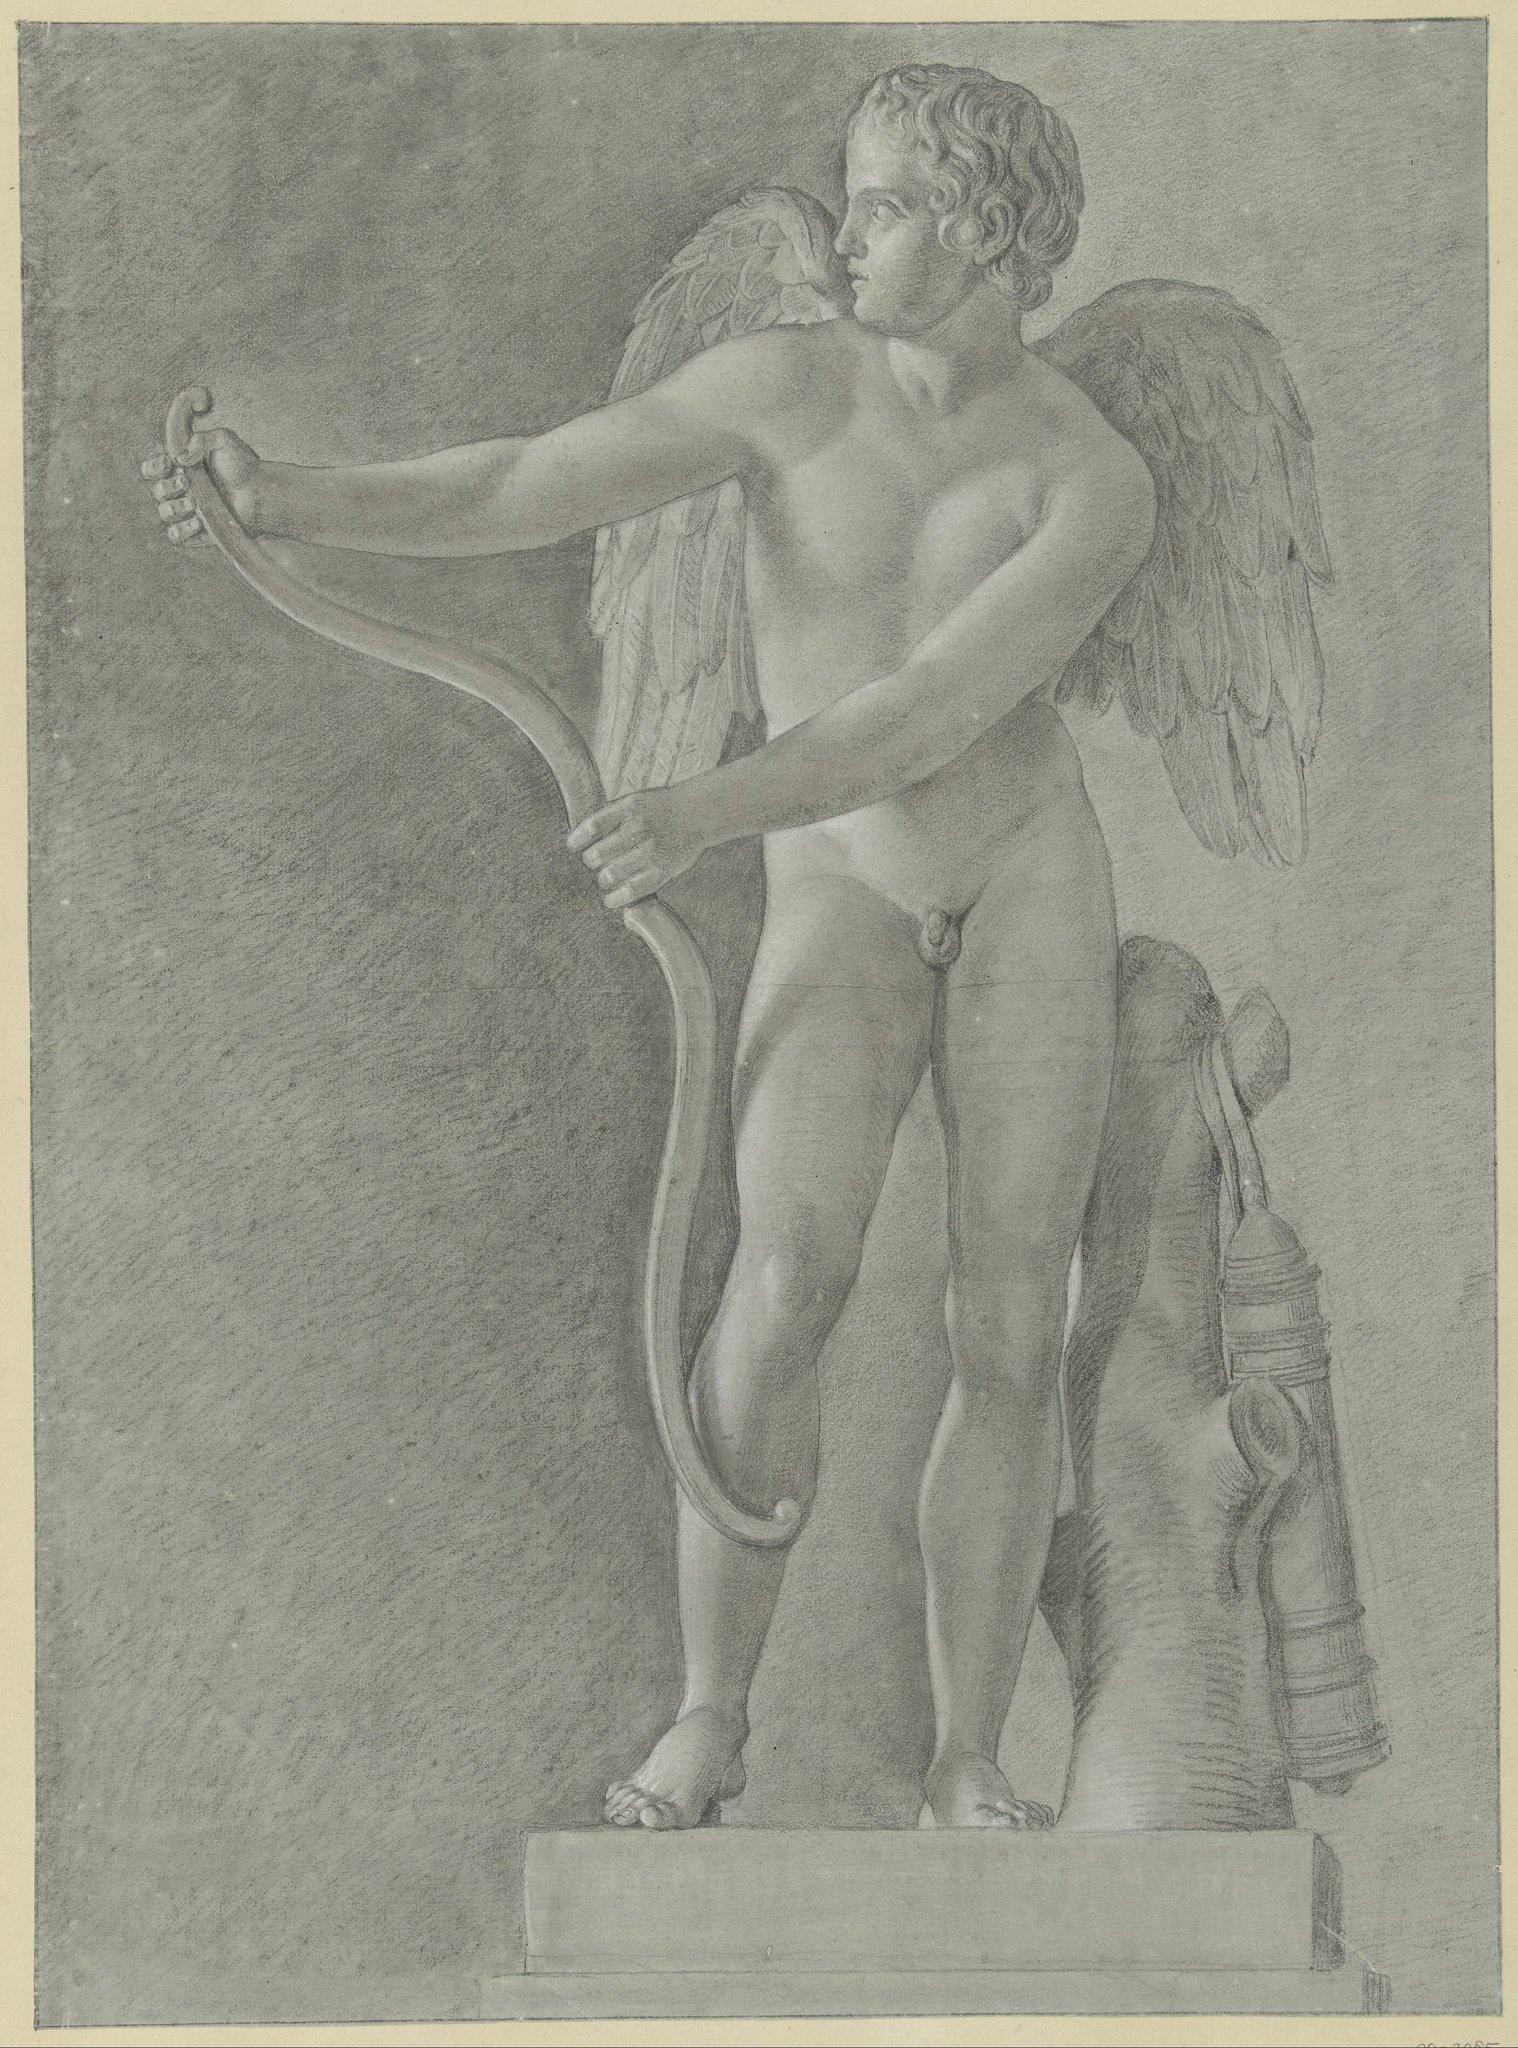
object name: drawing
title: Studie naar een standbeeld van Cupido die zijn boog spant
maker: jean grandjean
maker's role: draughtsman, print maker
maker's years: 1752-1781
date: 1765-1781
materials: chalk, paper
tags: piece of sculpture, reproduction of a piece of sculpture, cupid making his bow